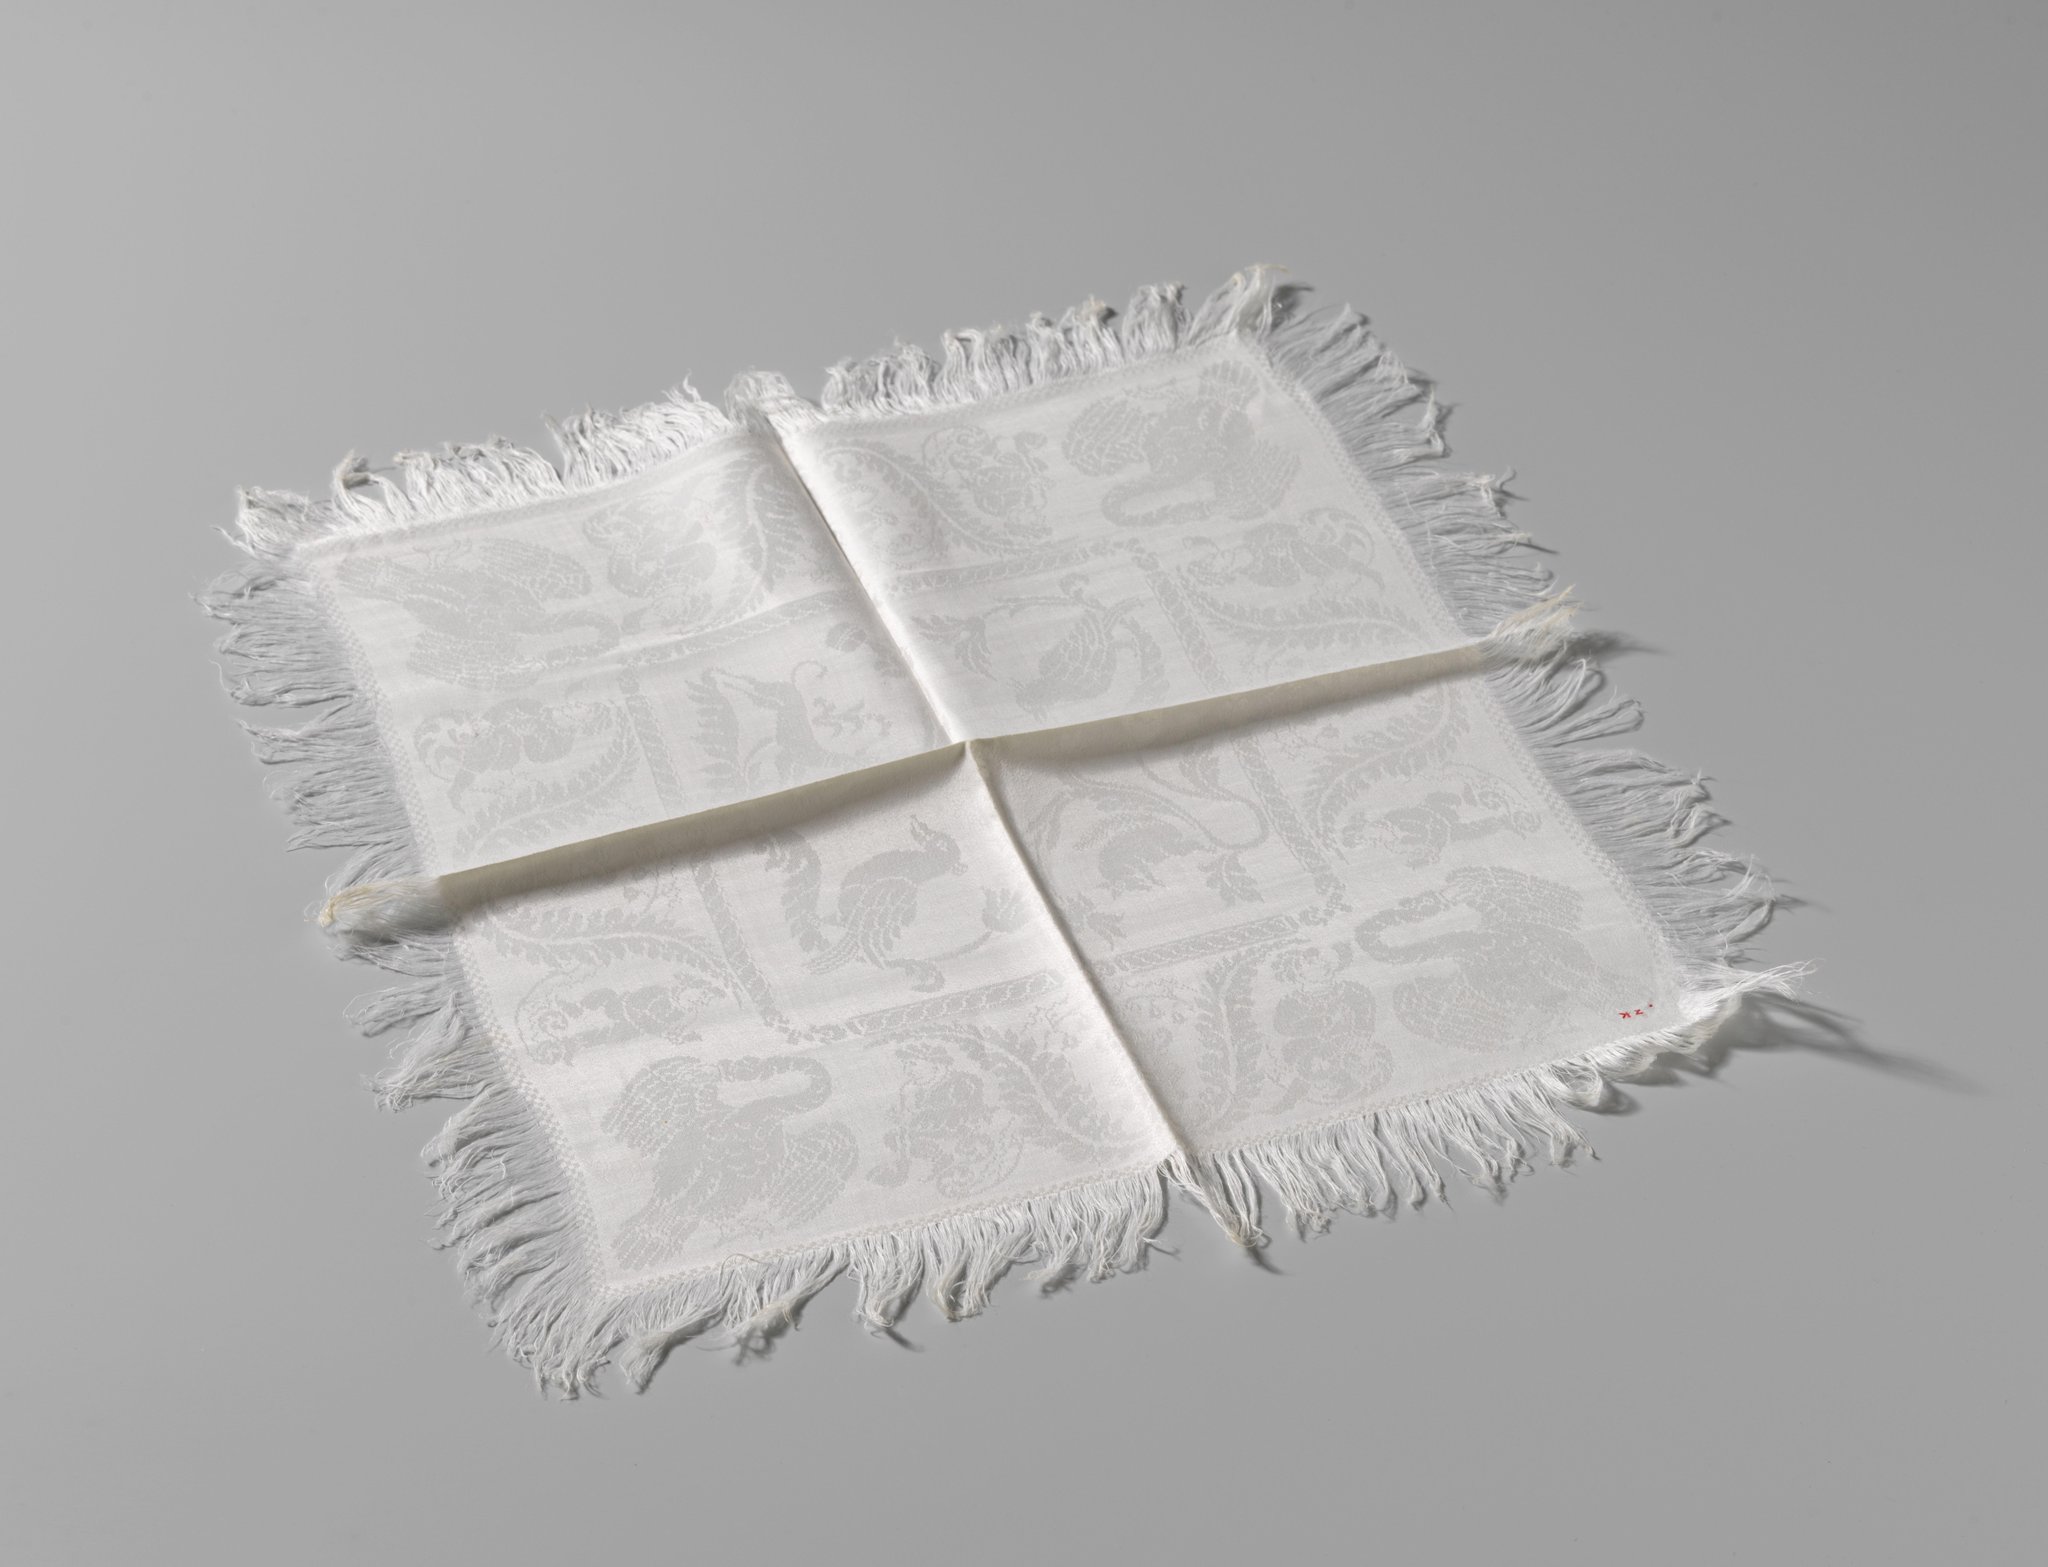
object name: napkin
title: Pijprokende Turken.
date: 1850-1899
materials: linen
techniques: damask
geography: veghel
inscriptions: mark: ‘KZ’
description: Vingerdoek van linnendamast met dessin van pijprokende Turken. Nederland, Veghel, firma Rath, 2de helft 19de eeuw.